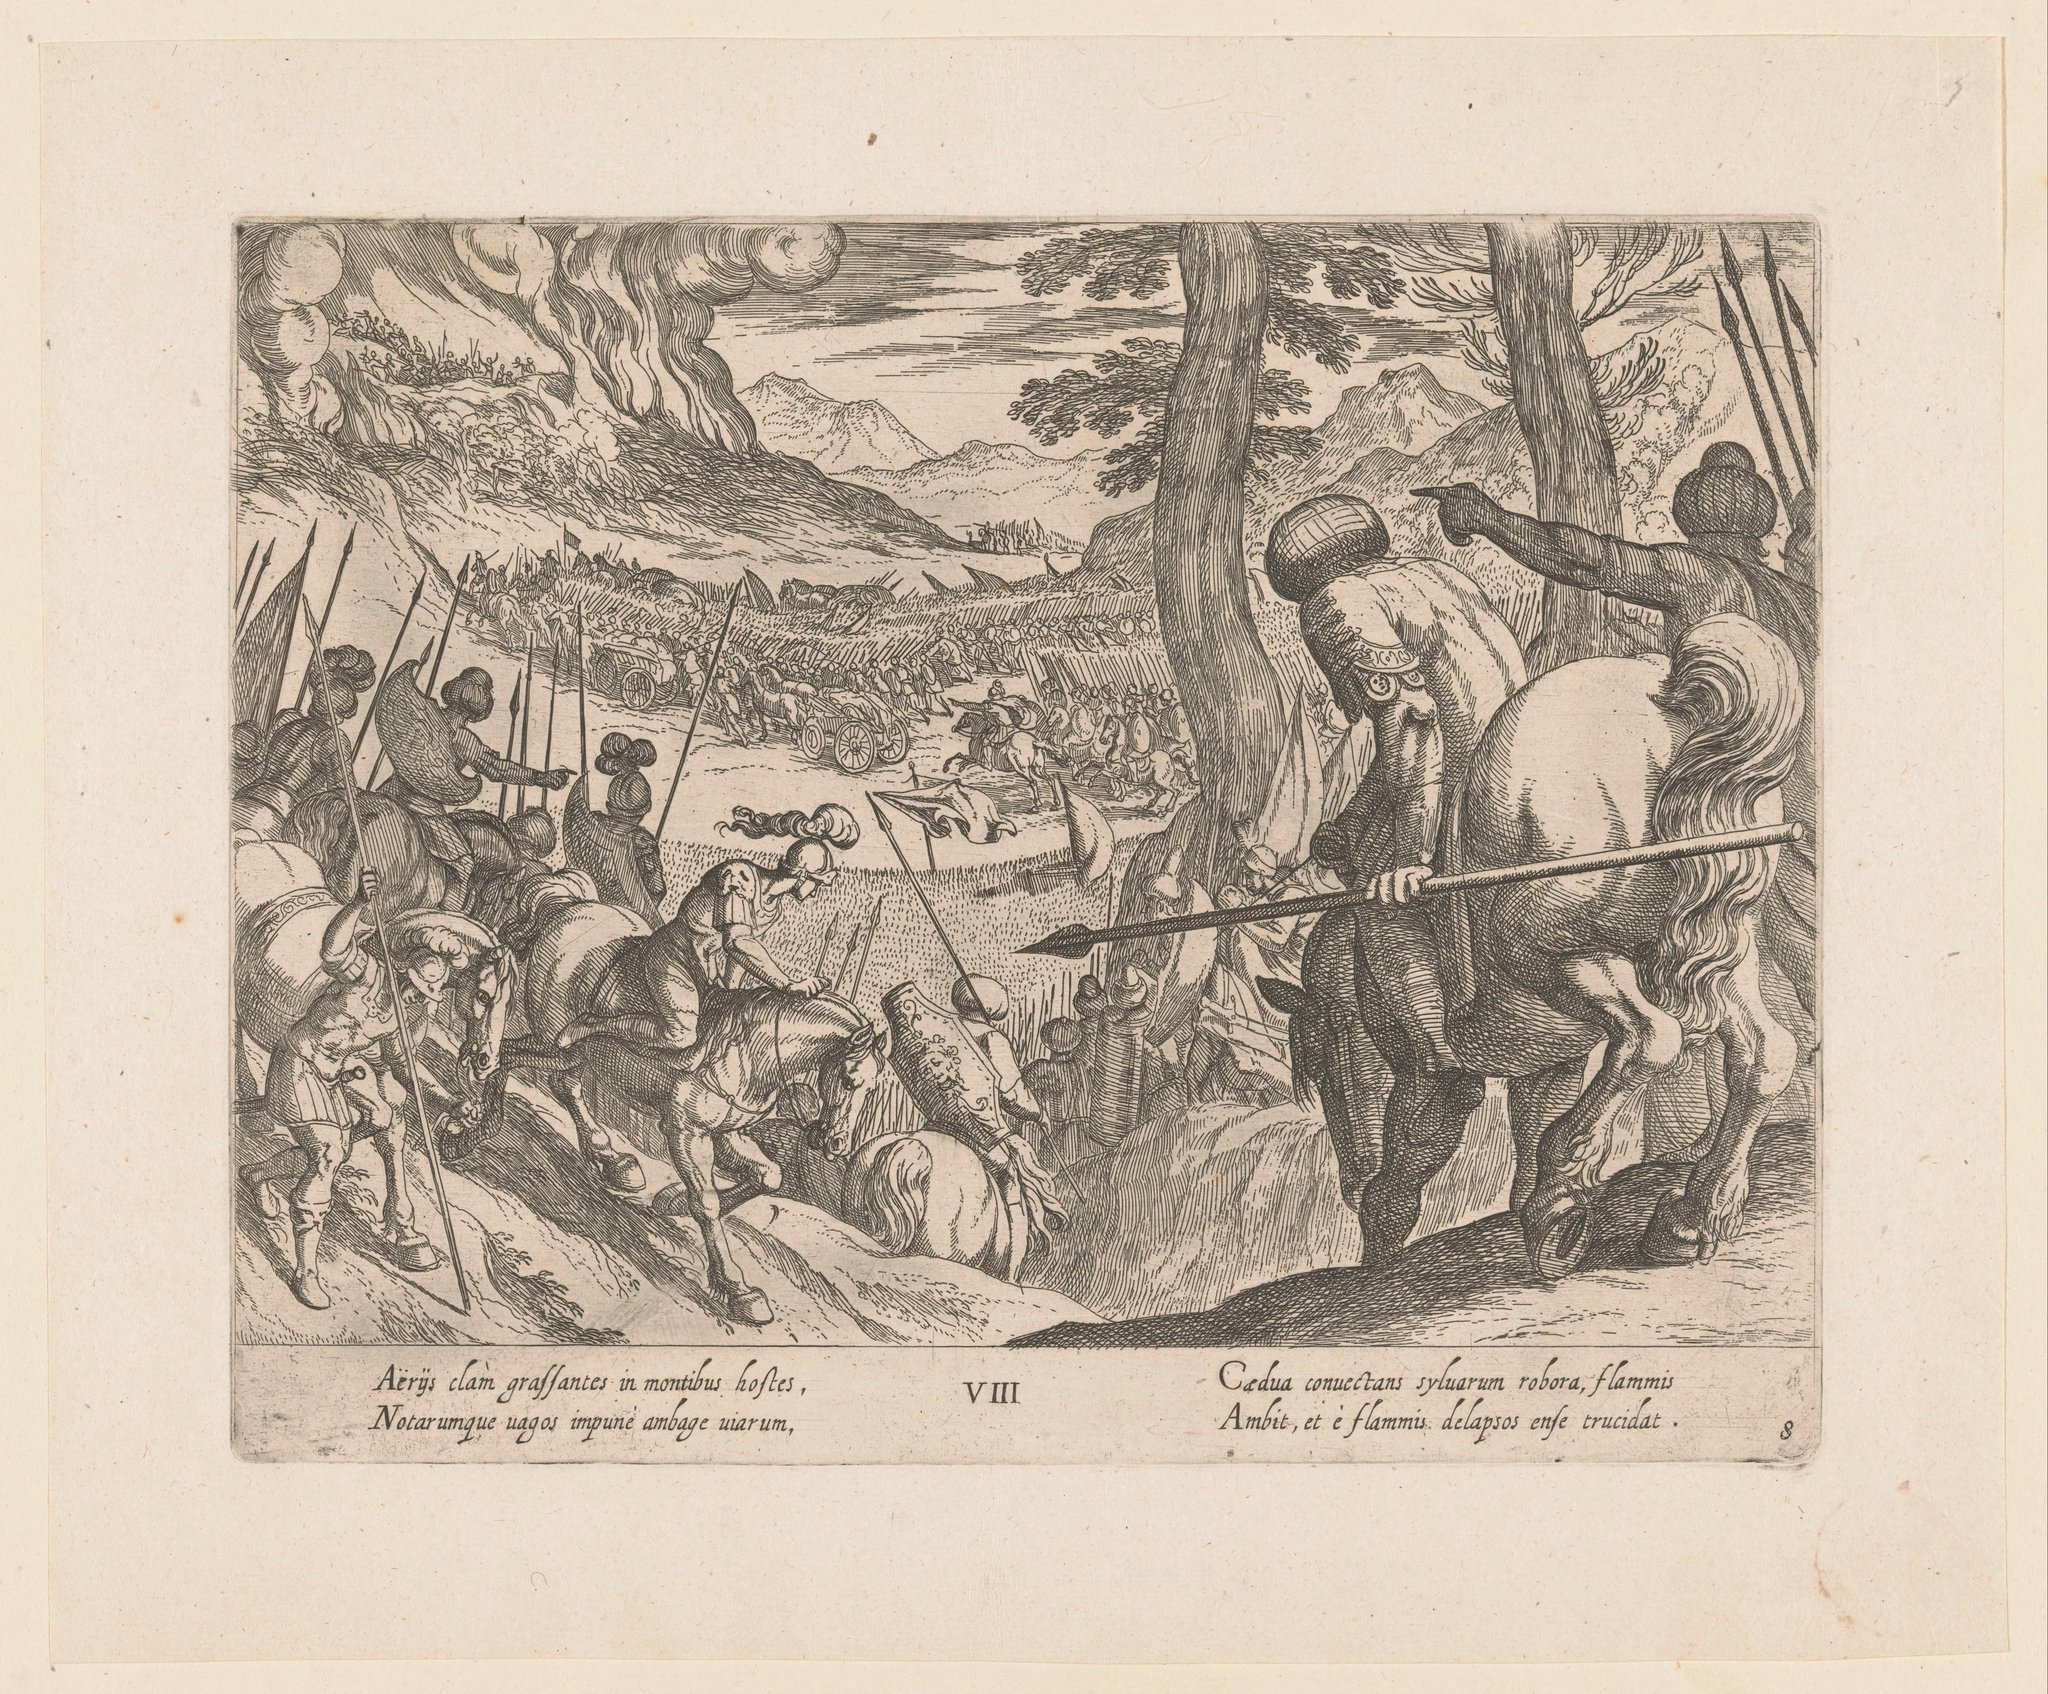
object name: print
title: De daden van Alexander de Grote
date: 1596-1652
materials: paper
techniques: etching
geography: italy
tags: battles of alexander, battle, the soldier; the soldier's life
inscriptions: collector's mark: Lugt 240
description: Het leger van Alexander de Grote sluit de vijandelijke troepen in met behulp van vuur in een bergdal. Vierregelig vers in het Latijn in twee kolommen in ondermarge.